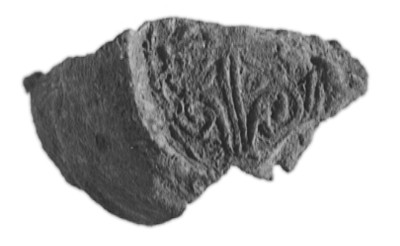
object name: sealing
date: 2030-1640 BCE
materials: clay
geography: egypt